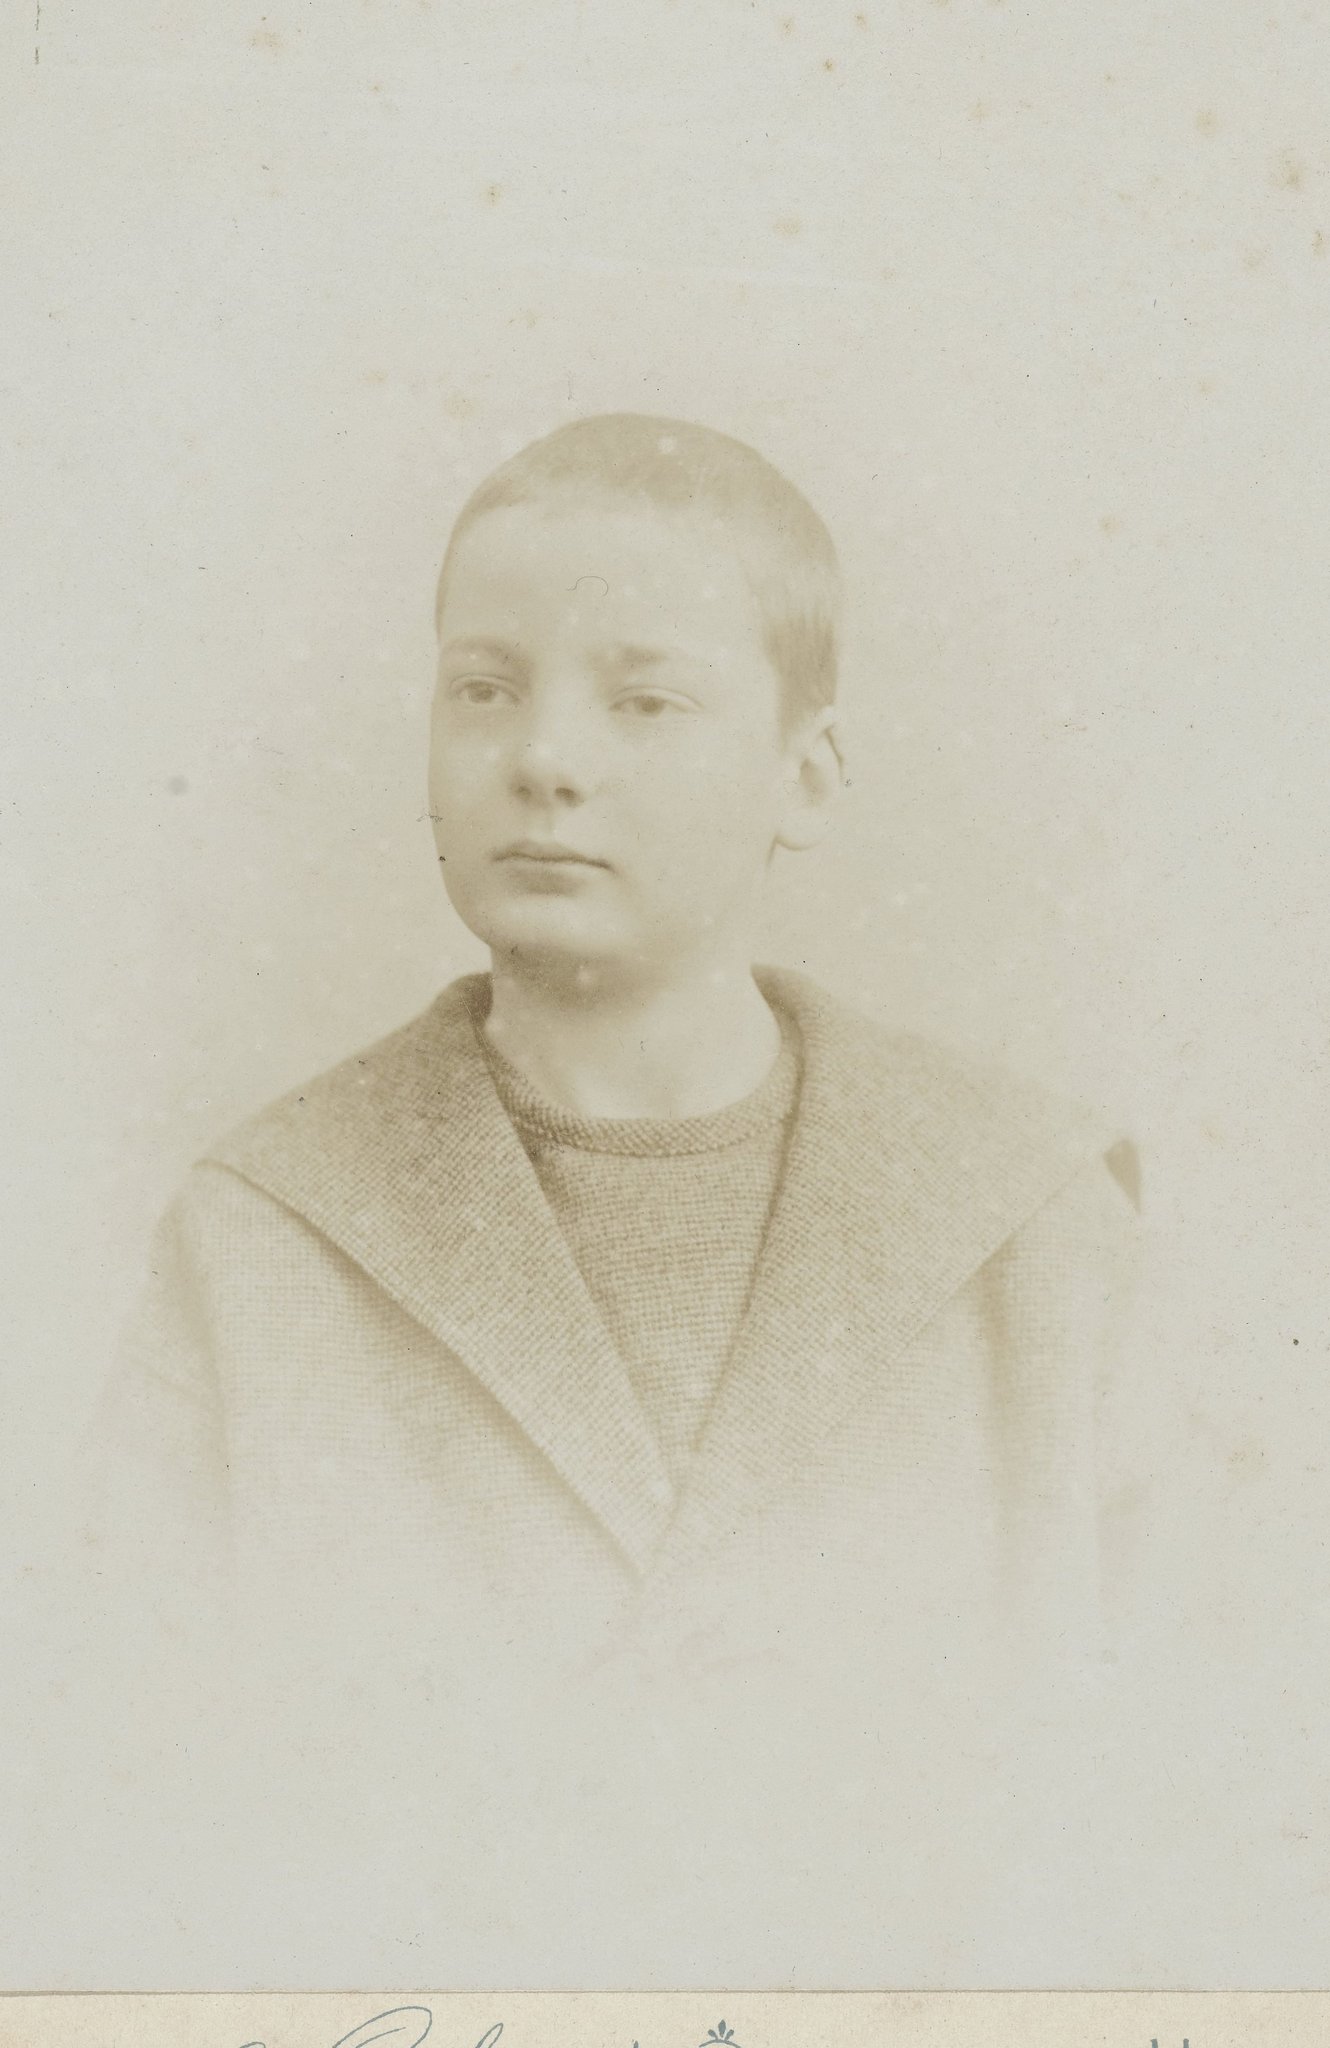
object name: cabinet photograph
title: David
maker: cornelis johannes lodewicus vermeulen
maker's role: fotograaf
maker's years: 1861-1936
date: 1880-1920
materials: cardboard, photographic support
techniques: albumen print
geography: the hague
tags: chest, bust, netherlands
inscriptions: name: ‘C.J.L. Vermeulen Den Haag Toussaintkade 11, Amsterdam Heiligenweg hoek Singel, Utrecht Nieuwe Gracht 50’